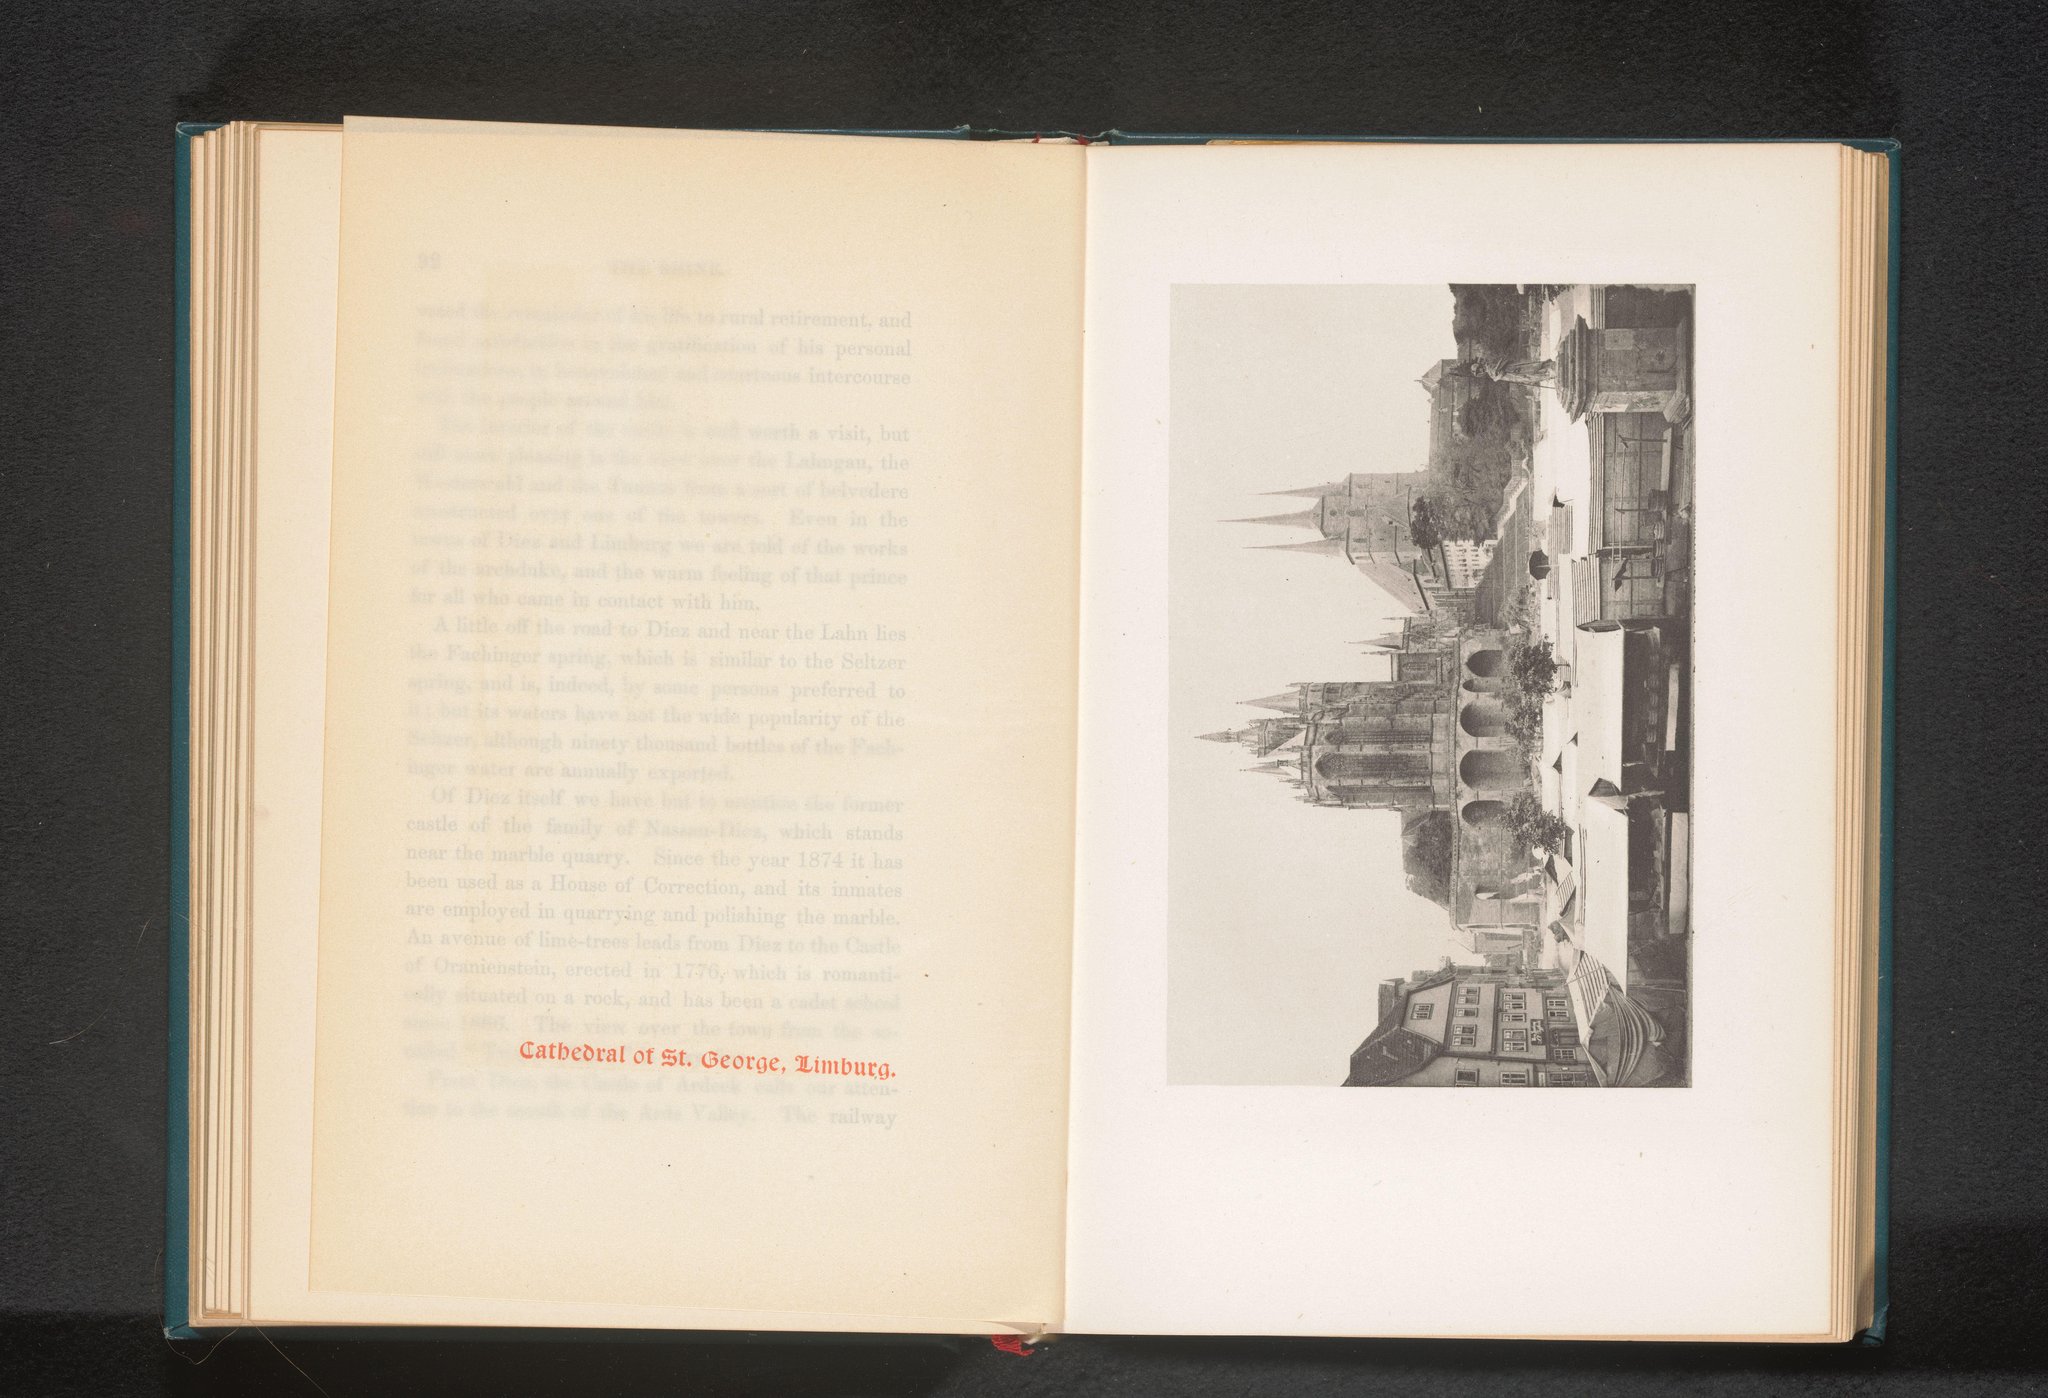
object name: page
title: Gezicht op een kerk (vermoedelijk) te Limburg an der Lahn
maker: Anonymous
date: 1889-1899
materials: paper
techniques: photoaquatint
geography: limburg an der lahn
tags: façade (of house or building)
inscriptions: title: ‘Cathedral of St. George, Limburg.’